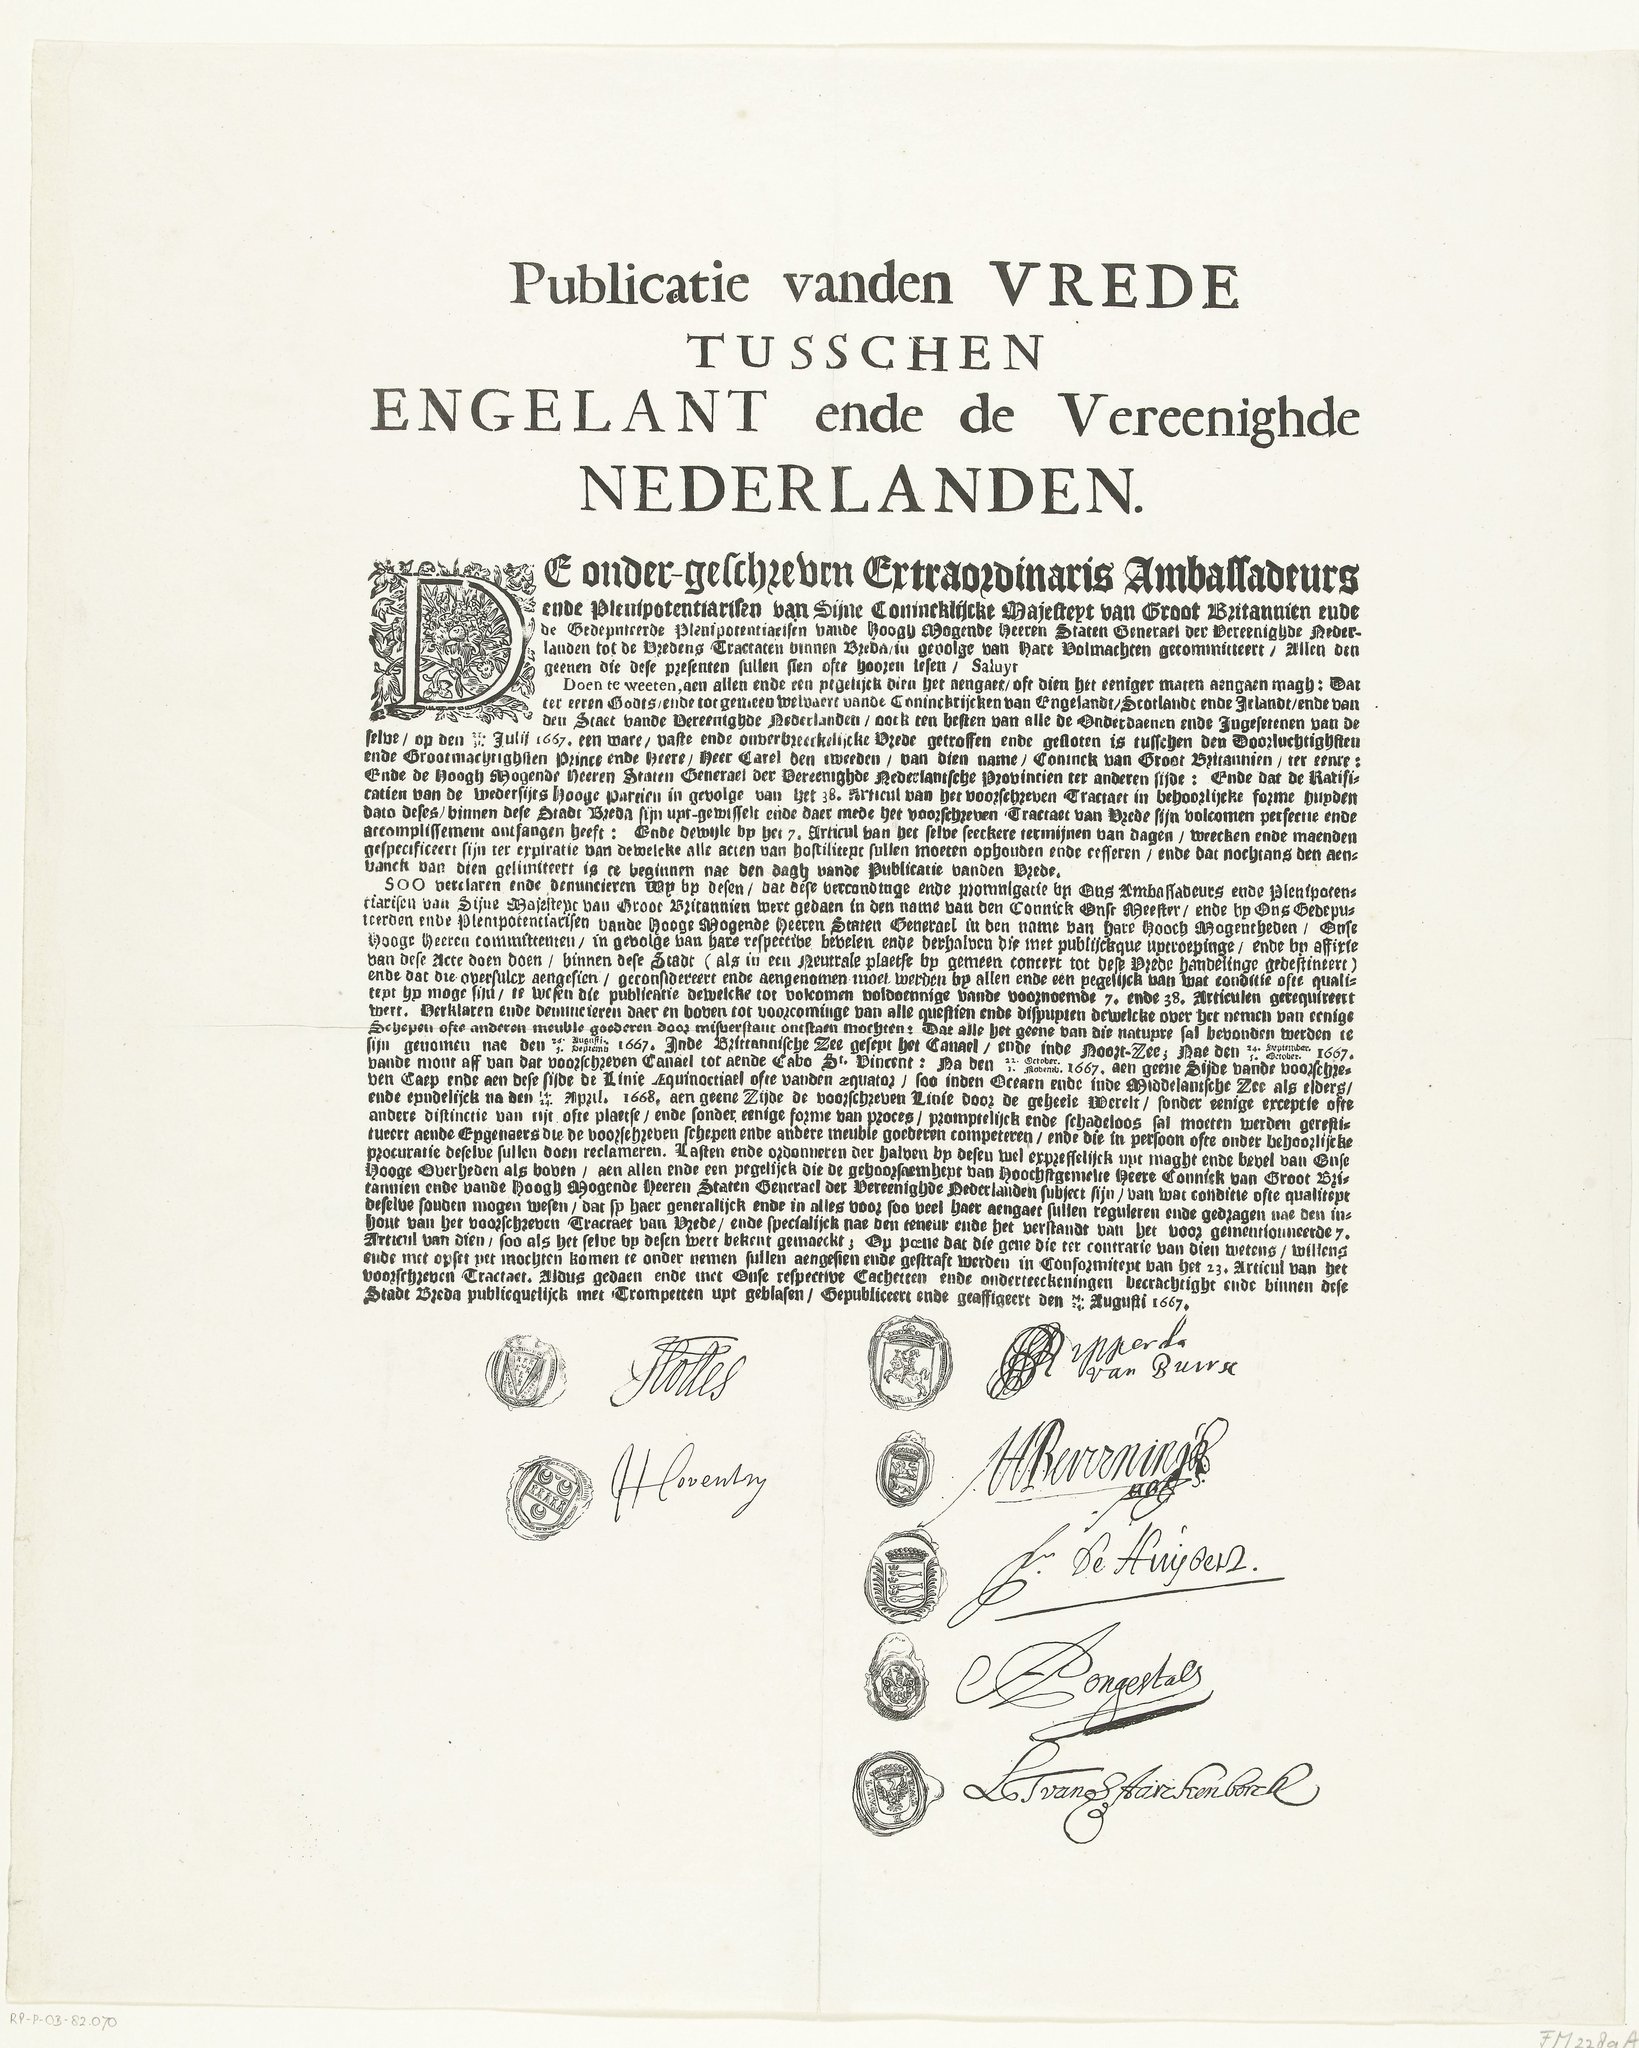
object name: historical object representation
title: Publicatie van de ratificatie van de Vrede te Breda, 1667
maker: Anonymous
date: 1800-1881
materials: paper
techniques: lithograph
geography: low countries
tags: vrede van breda (1667)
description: Publicatie van de ratificatie van de Vrede te Breda, gepubliceerd in het Nederlands op 24 augustus 1667. Met de handtekeningen en cachetten van de twee Engelse ambassadeurs D. Holles en H. Coventry en vijf Hollandse afgevaardigden Ripperda van Buirse, H. van Beverningh, Pr. de Huijbert, A.P. Jongestall en L.T. van Starckenborch.